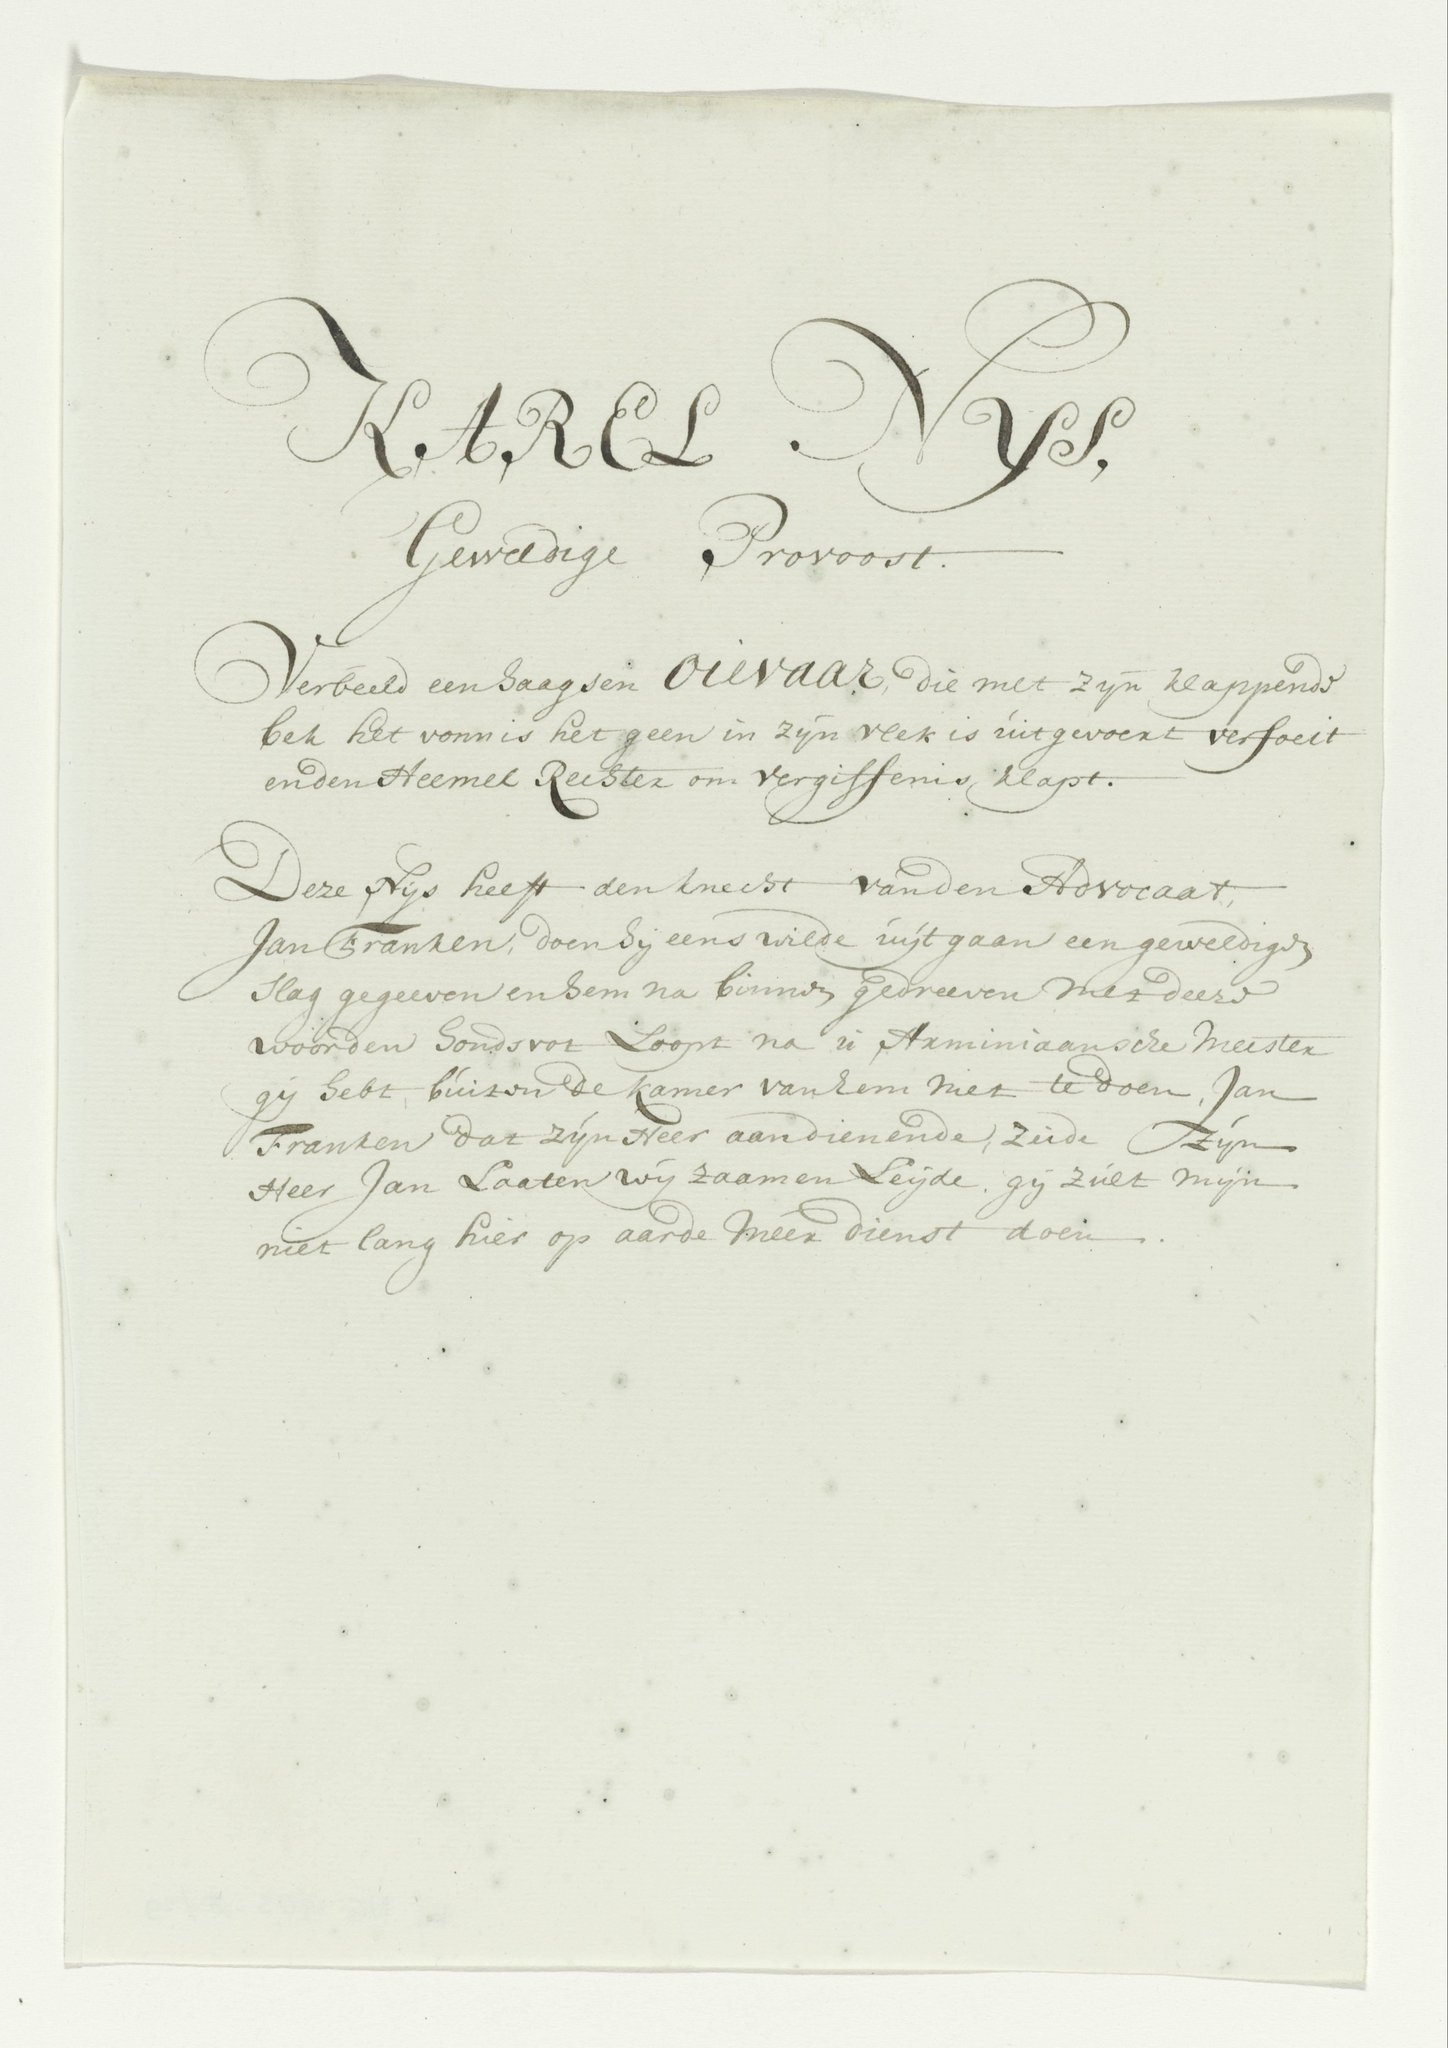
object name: manuscript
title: Spotvers bij het portret van Karel Nys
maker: Anonymous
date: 1710-1720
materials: paper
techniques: pen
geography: netherlands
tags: the hague, johan van oldenbarnevelt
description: Spotprent van Karel Nys, provoost van Van Oldenbarnevelt; ooievaar met kop in de lucht en wapen op de borst. In krans van bloemen en bladeren, daaronder cartouche met aan weerszijden twee jongetjes. In cartouche naam en daarboven 'provoost'. Behorende bij serie aquarellen in boek.